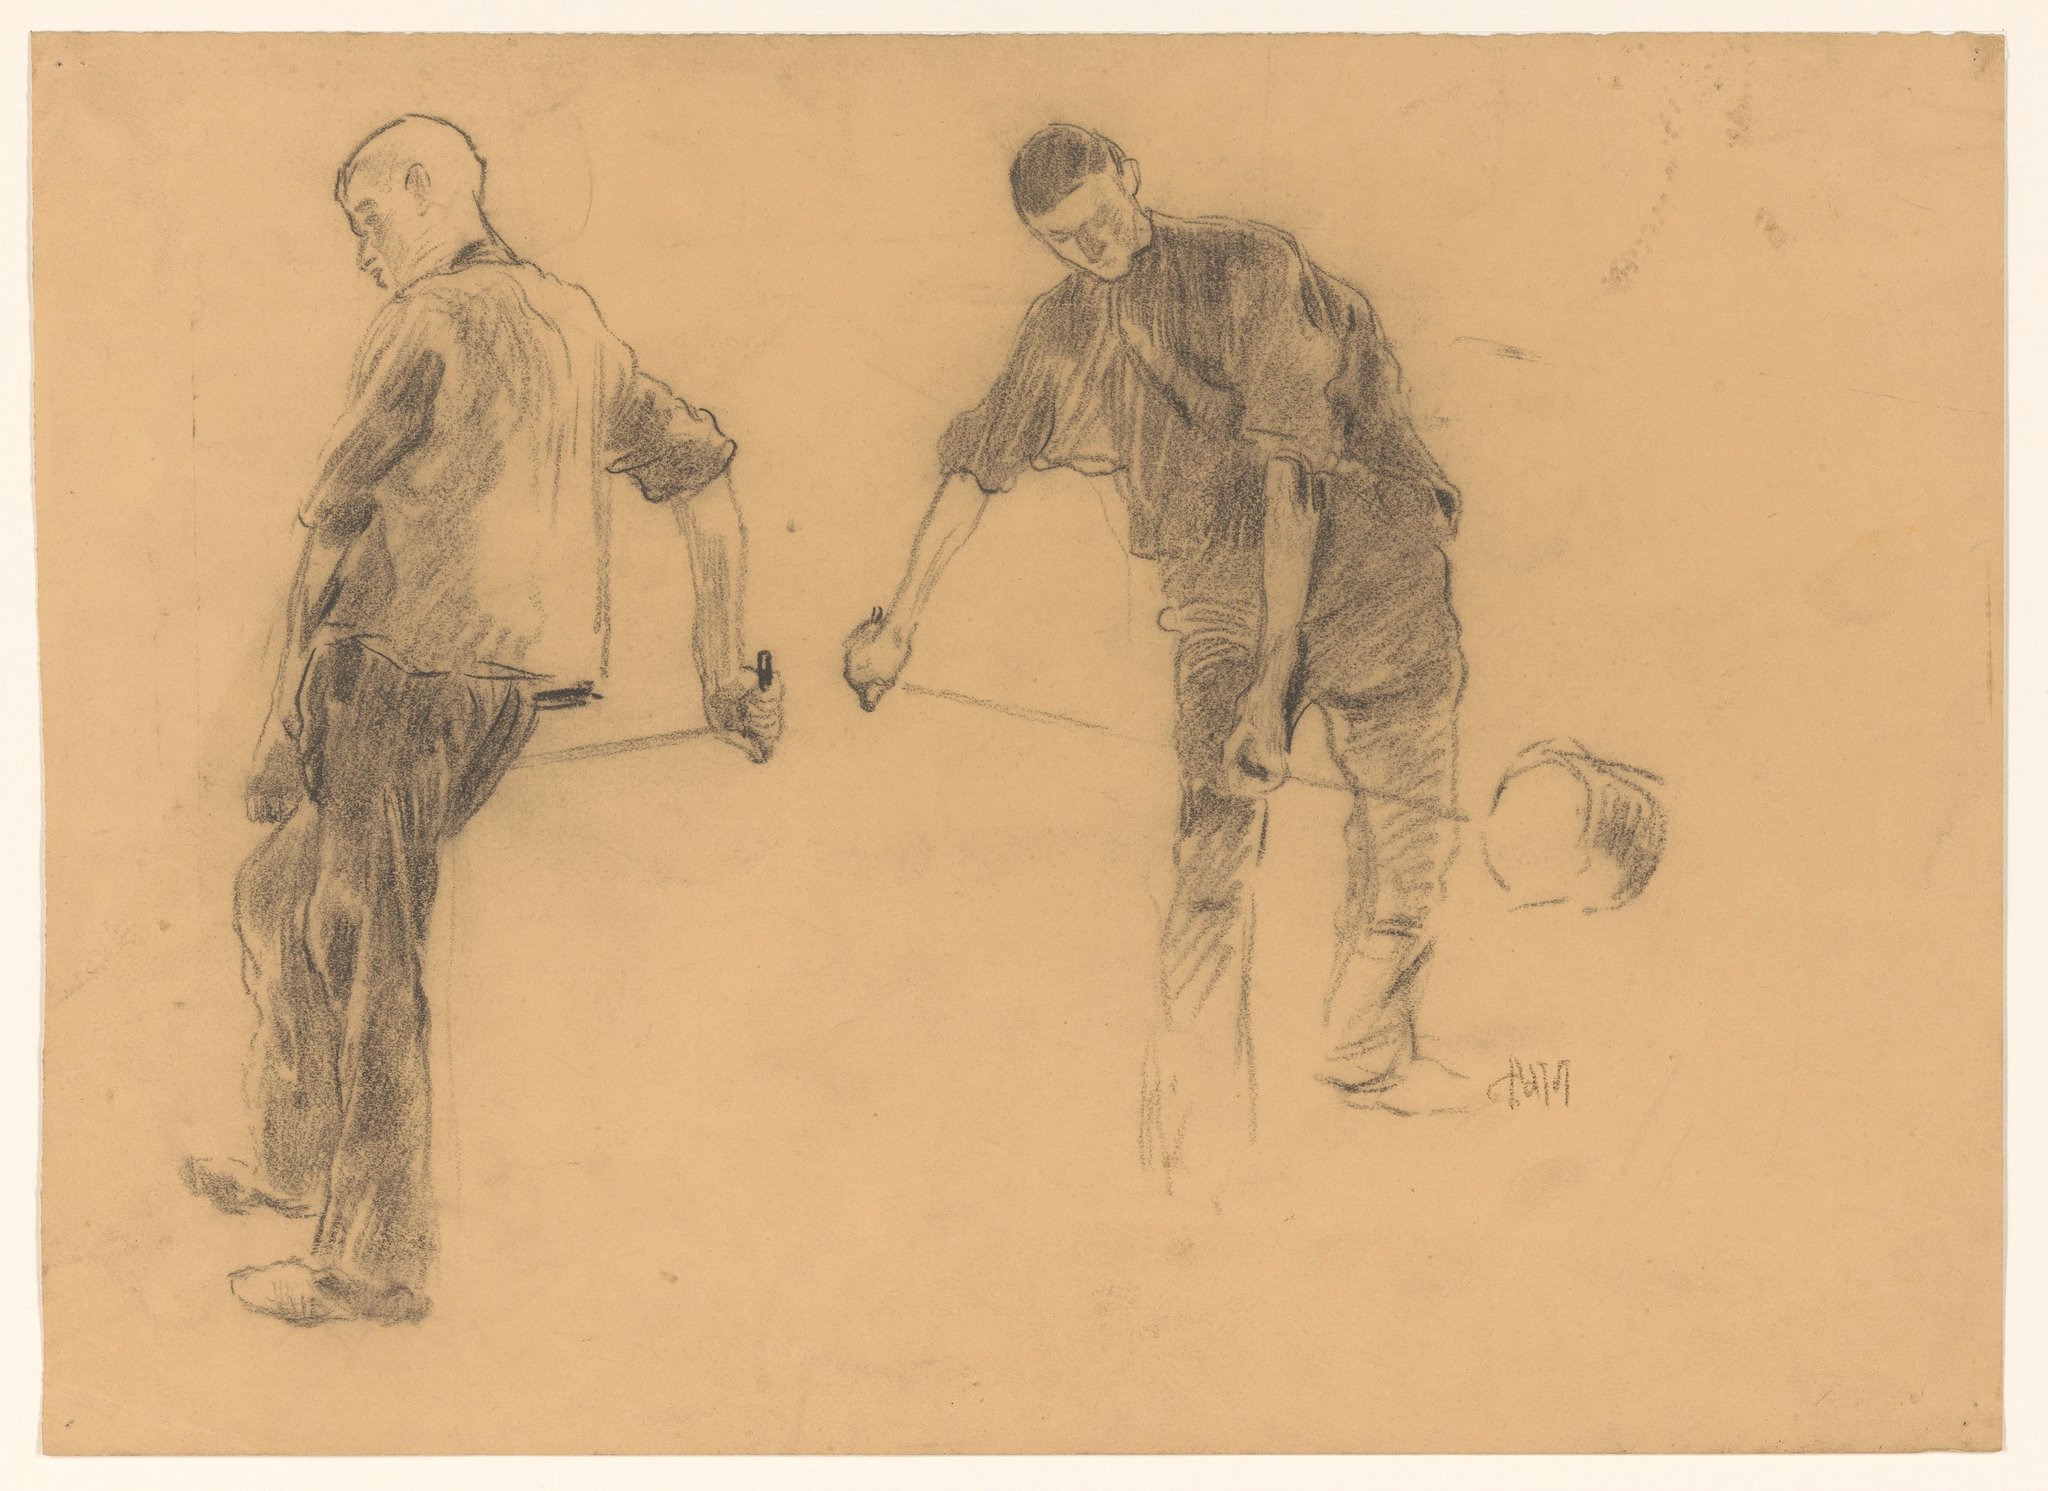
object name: drawing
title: Arbeider in metaalindustrie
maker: pieter de josselin de jong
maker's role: draughtsman, painter, print maker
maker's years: 1861-1906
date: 1871-1906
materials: chalk, paper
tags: iron and steel industry (+ men (labourers))